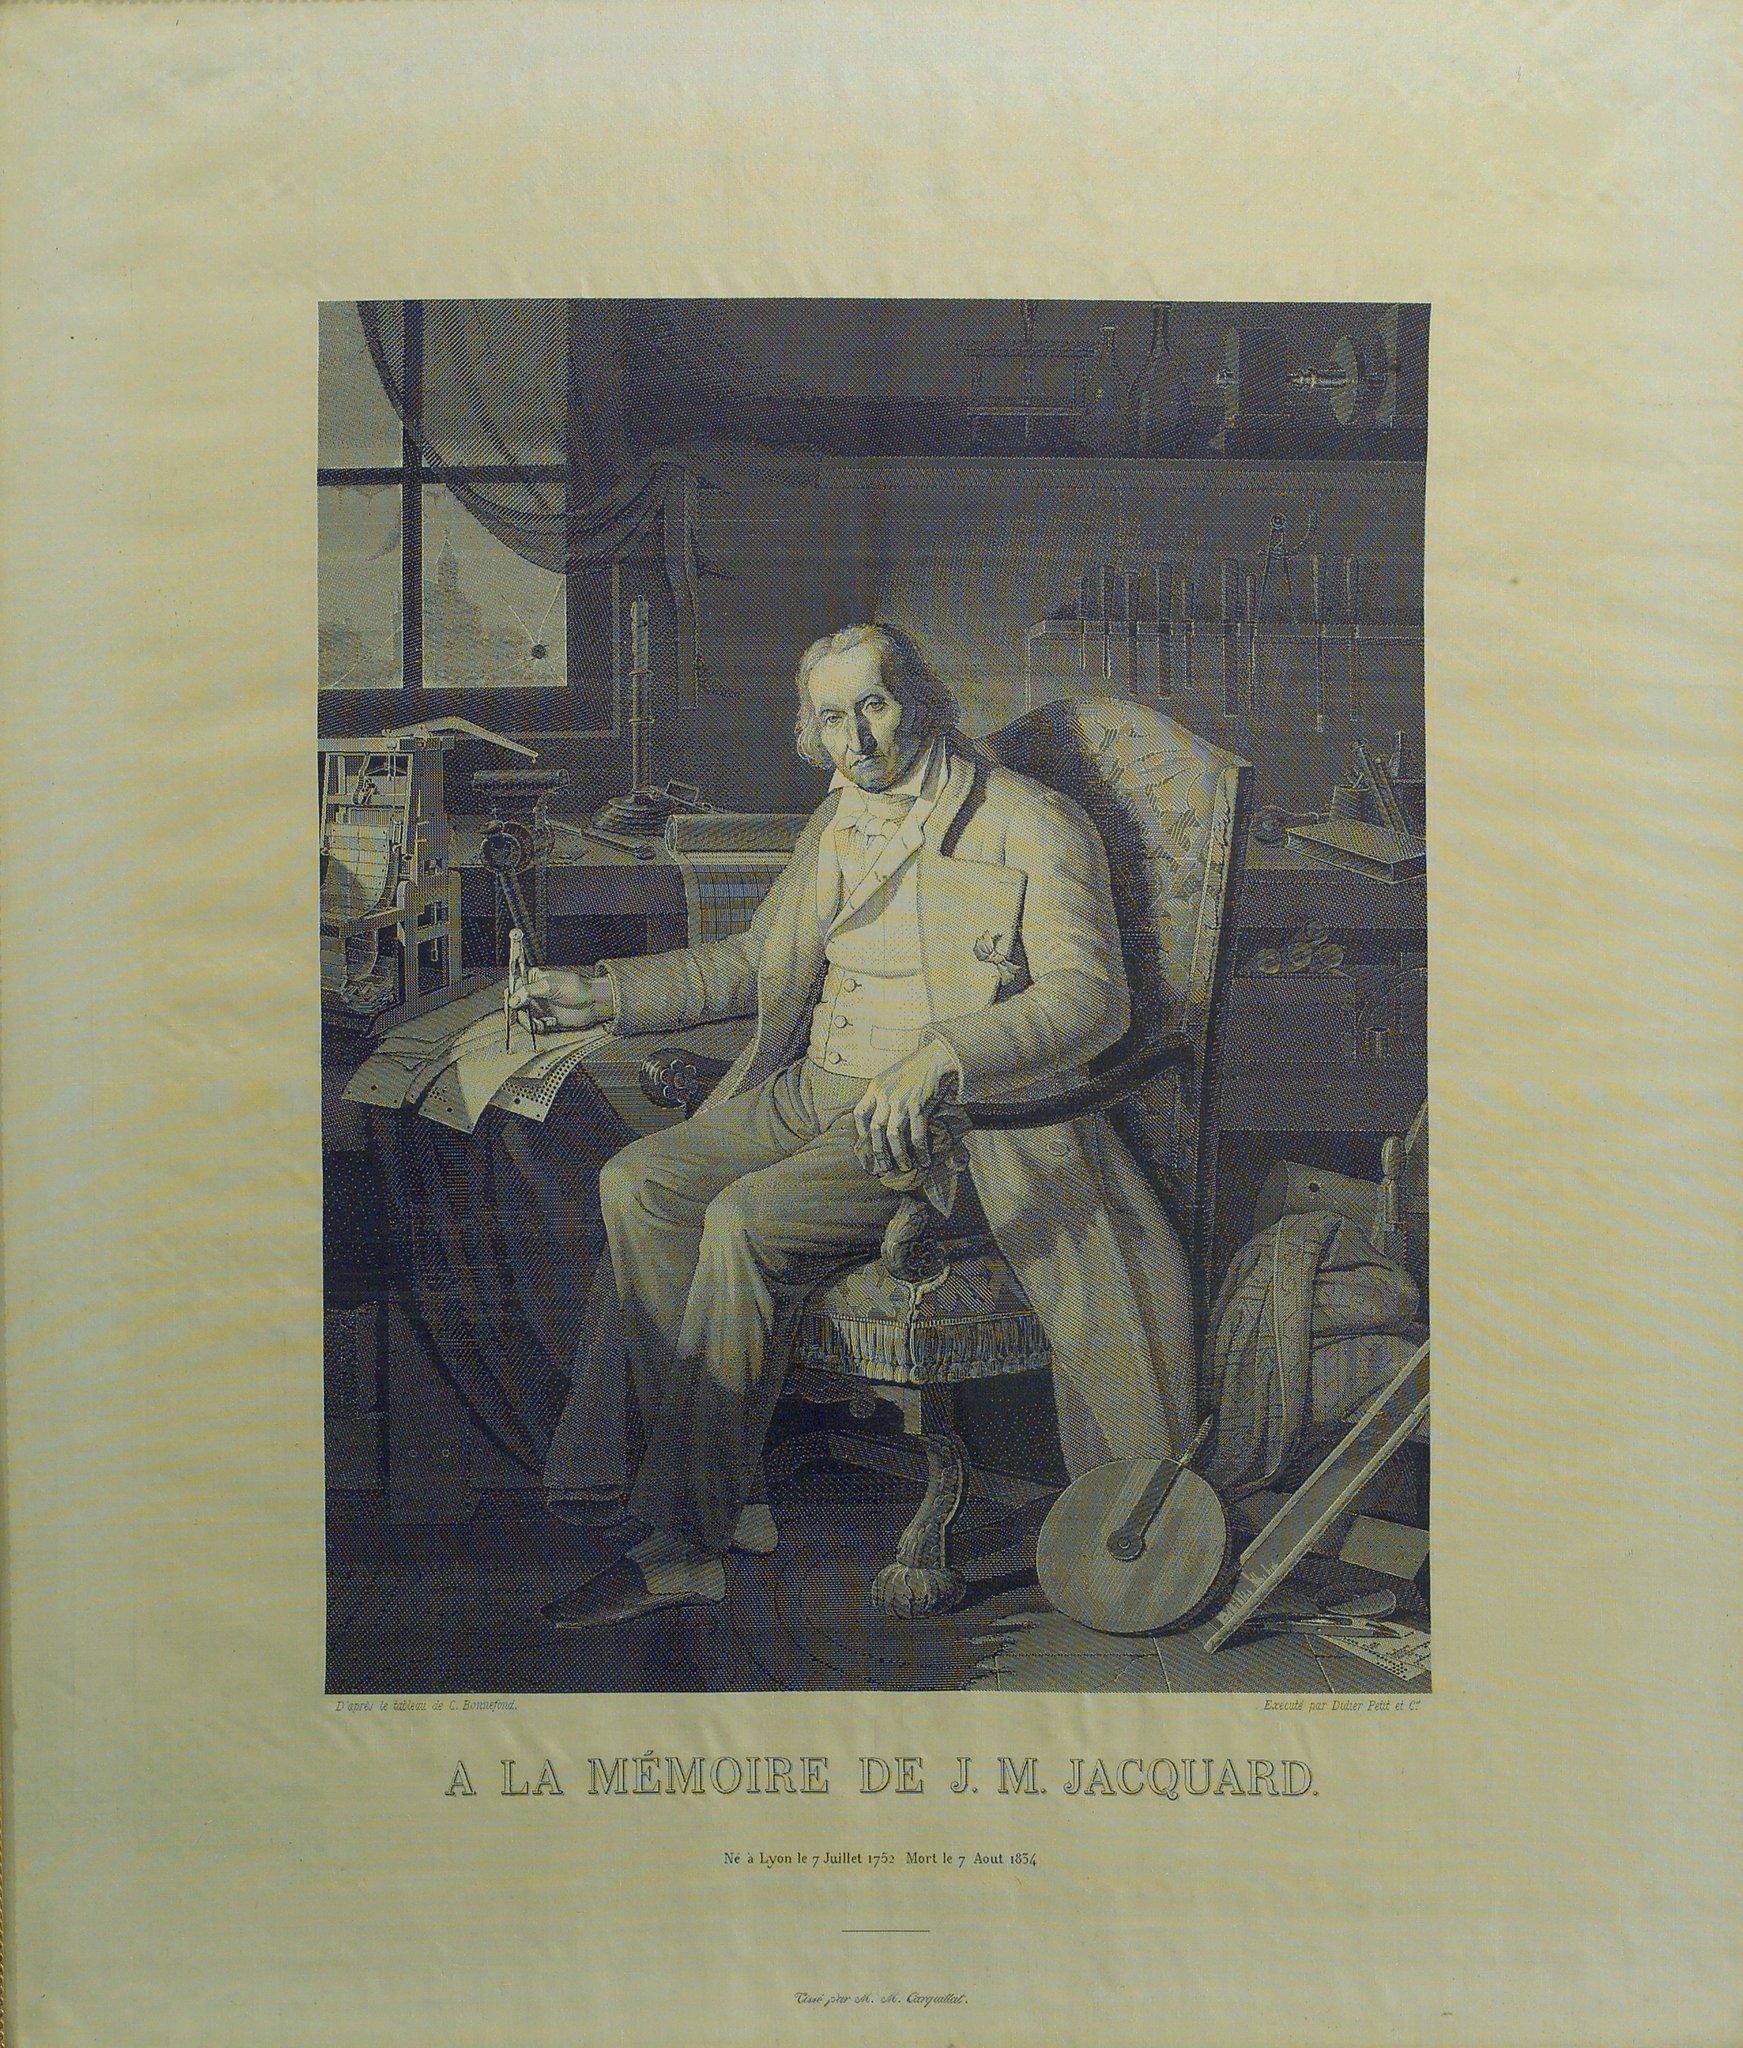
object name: silk weave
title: Joseph Marie Jacquard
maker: didier, petit et cie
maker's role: manufactory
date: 1839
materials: silk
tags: men,portraits,looms